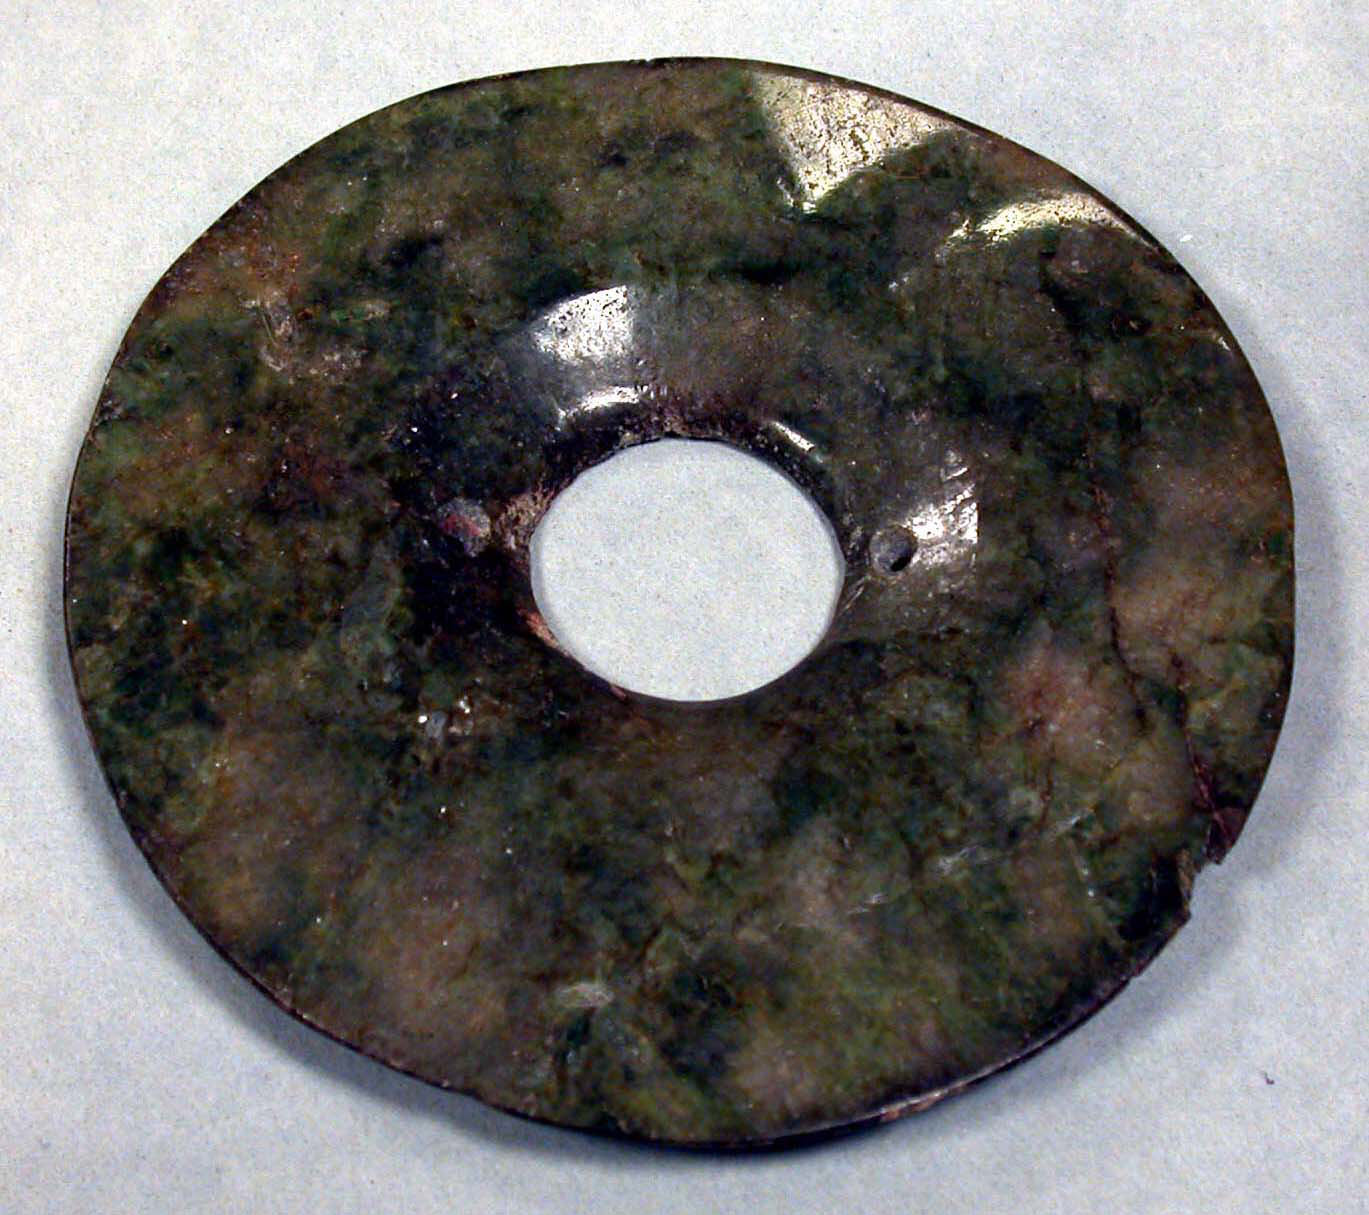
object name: earflare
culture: mexican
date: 1501-1600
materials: stone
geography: mexico